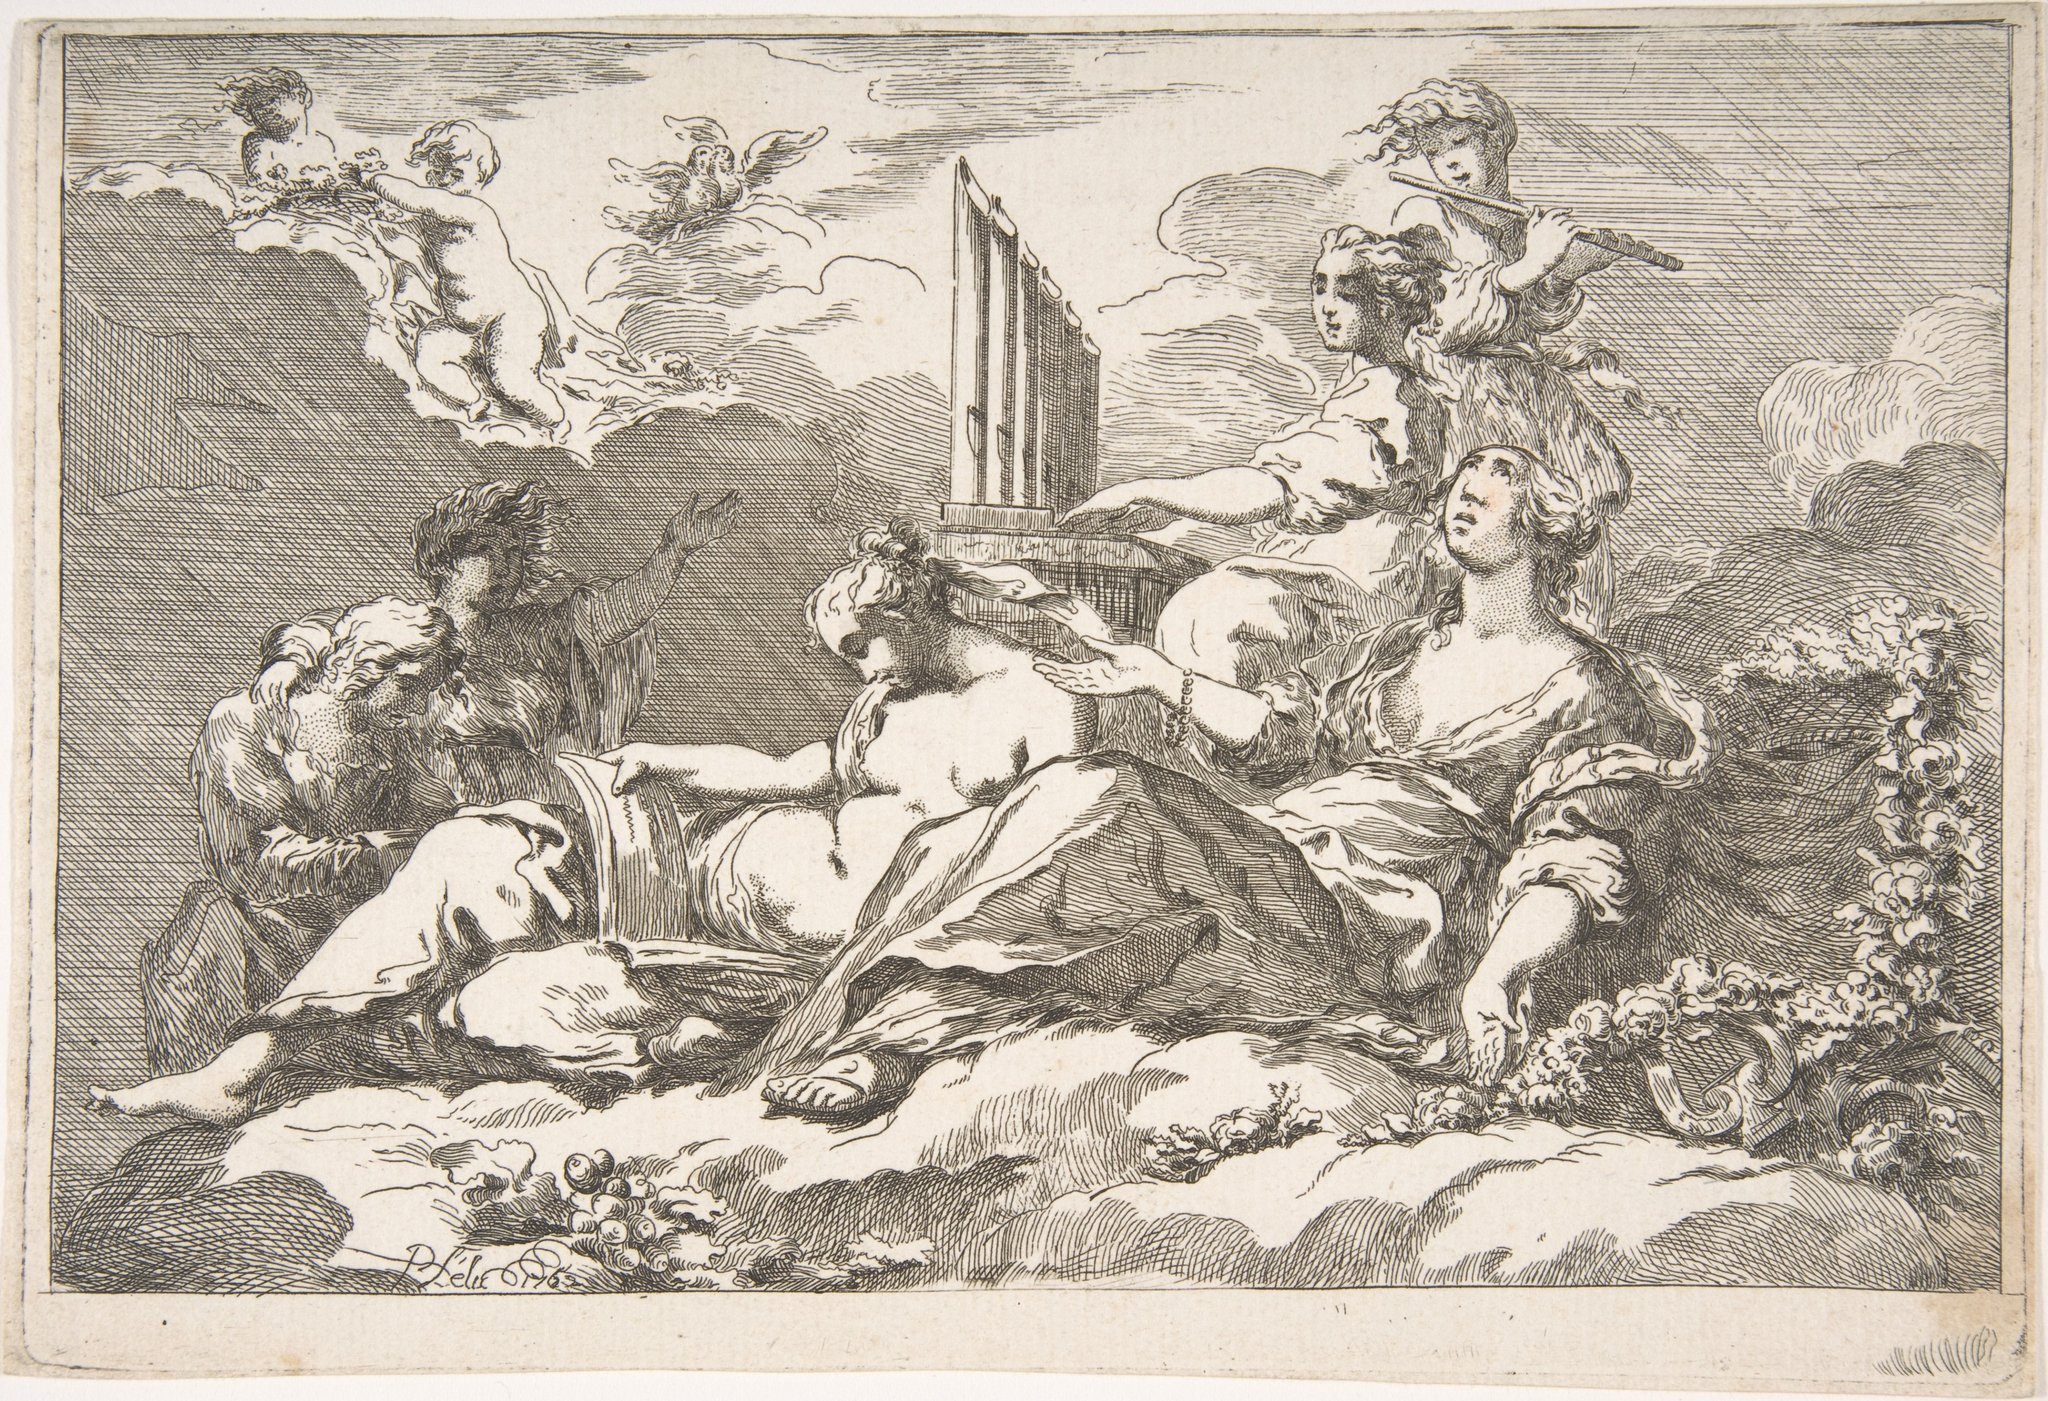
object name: print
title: The Harmony of Nature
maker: pierre lélu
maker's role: artist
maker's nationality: french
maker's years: 1741-1810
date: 1762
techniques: etching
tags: musical instruments,men,female nudes